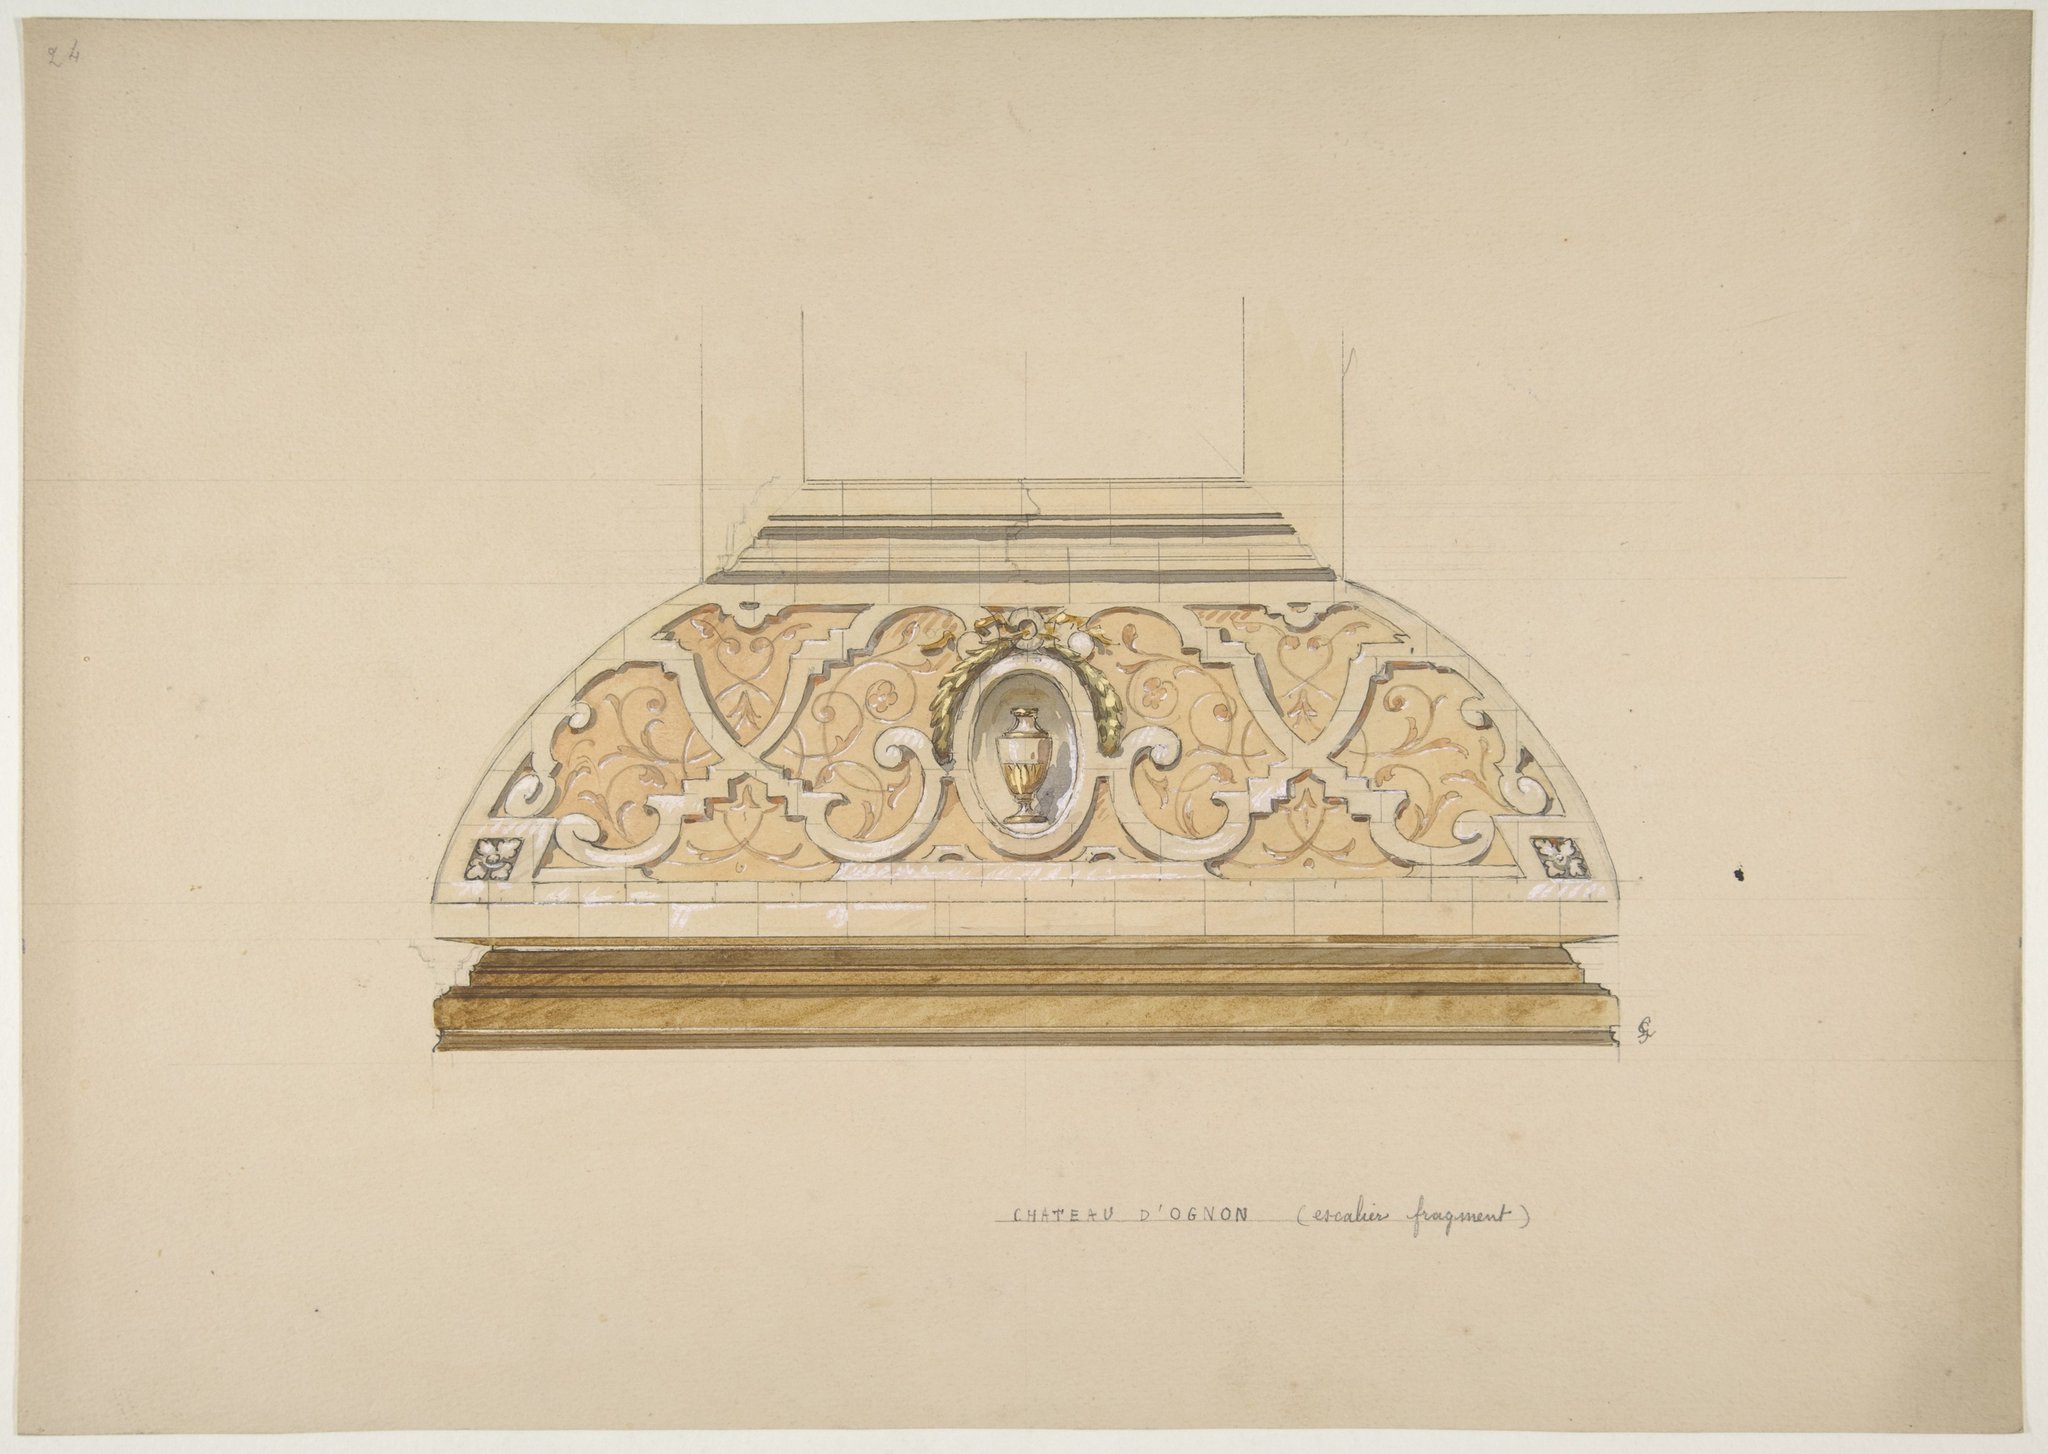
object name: drawing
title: Design for the decoration of the stairway in the Château d'Ognon of M. deMachy (Oise, France)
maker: jules-edmond-charles lachaise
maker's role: artist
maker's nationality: french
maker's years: 1897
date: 1851-1900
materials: gouache, graphite, ink, watercolor, paper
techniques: pen